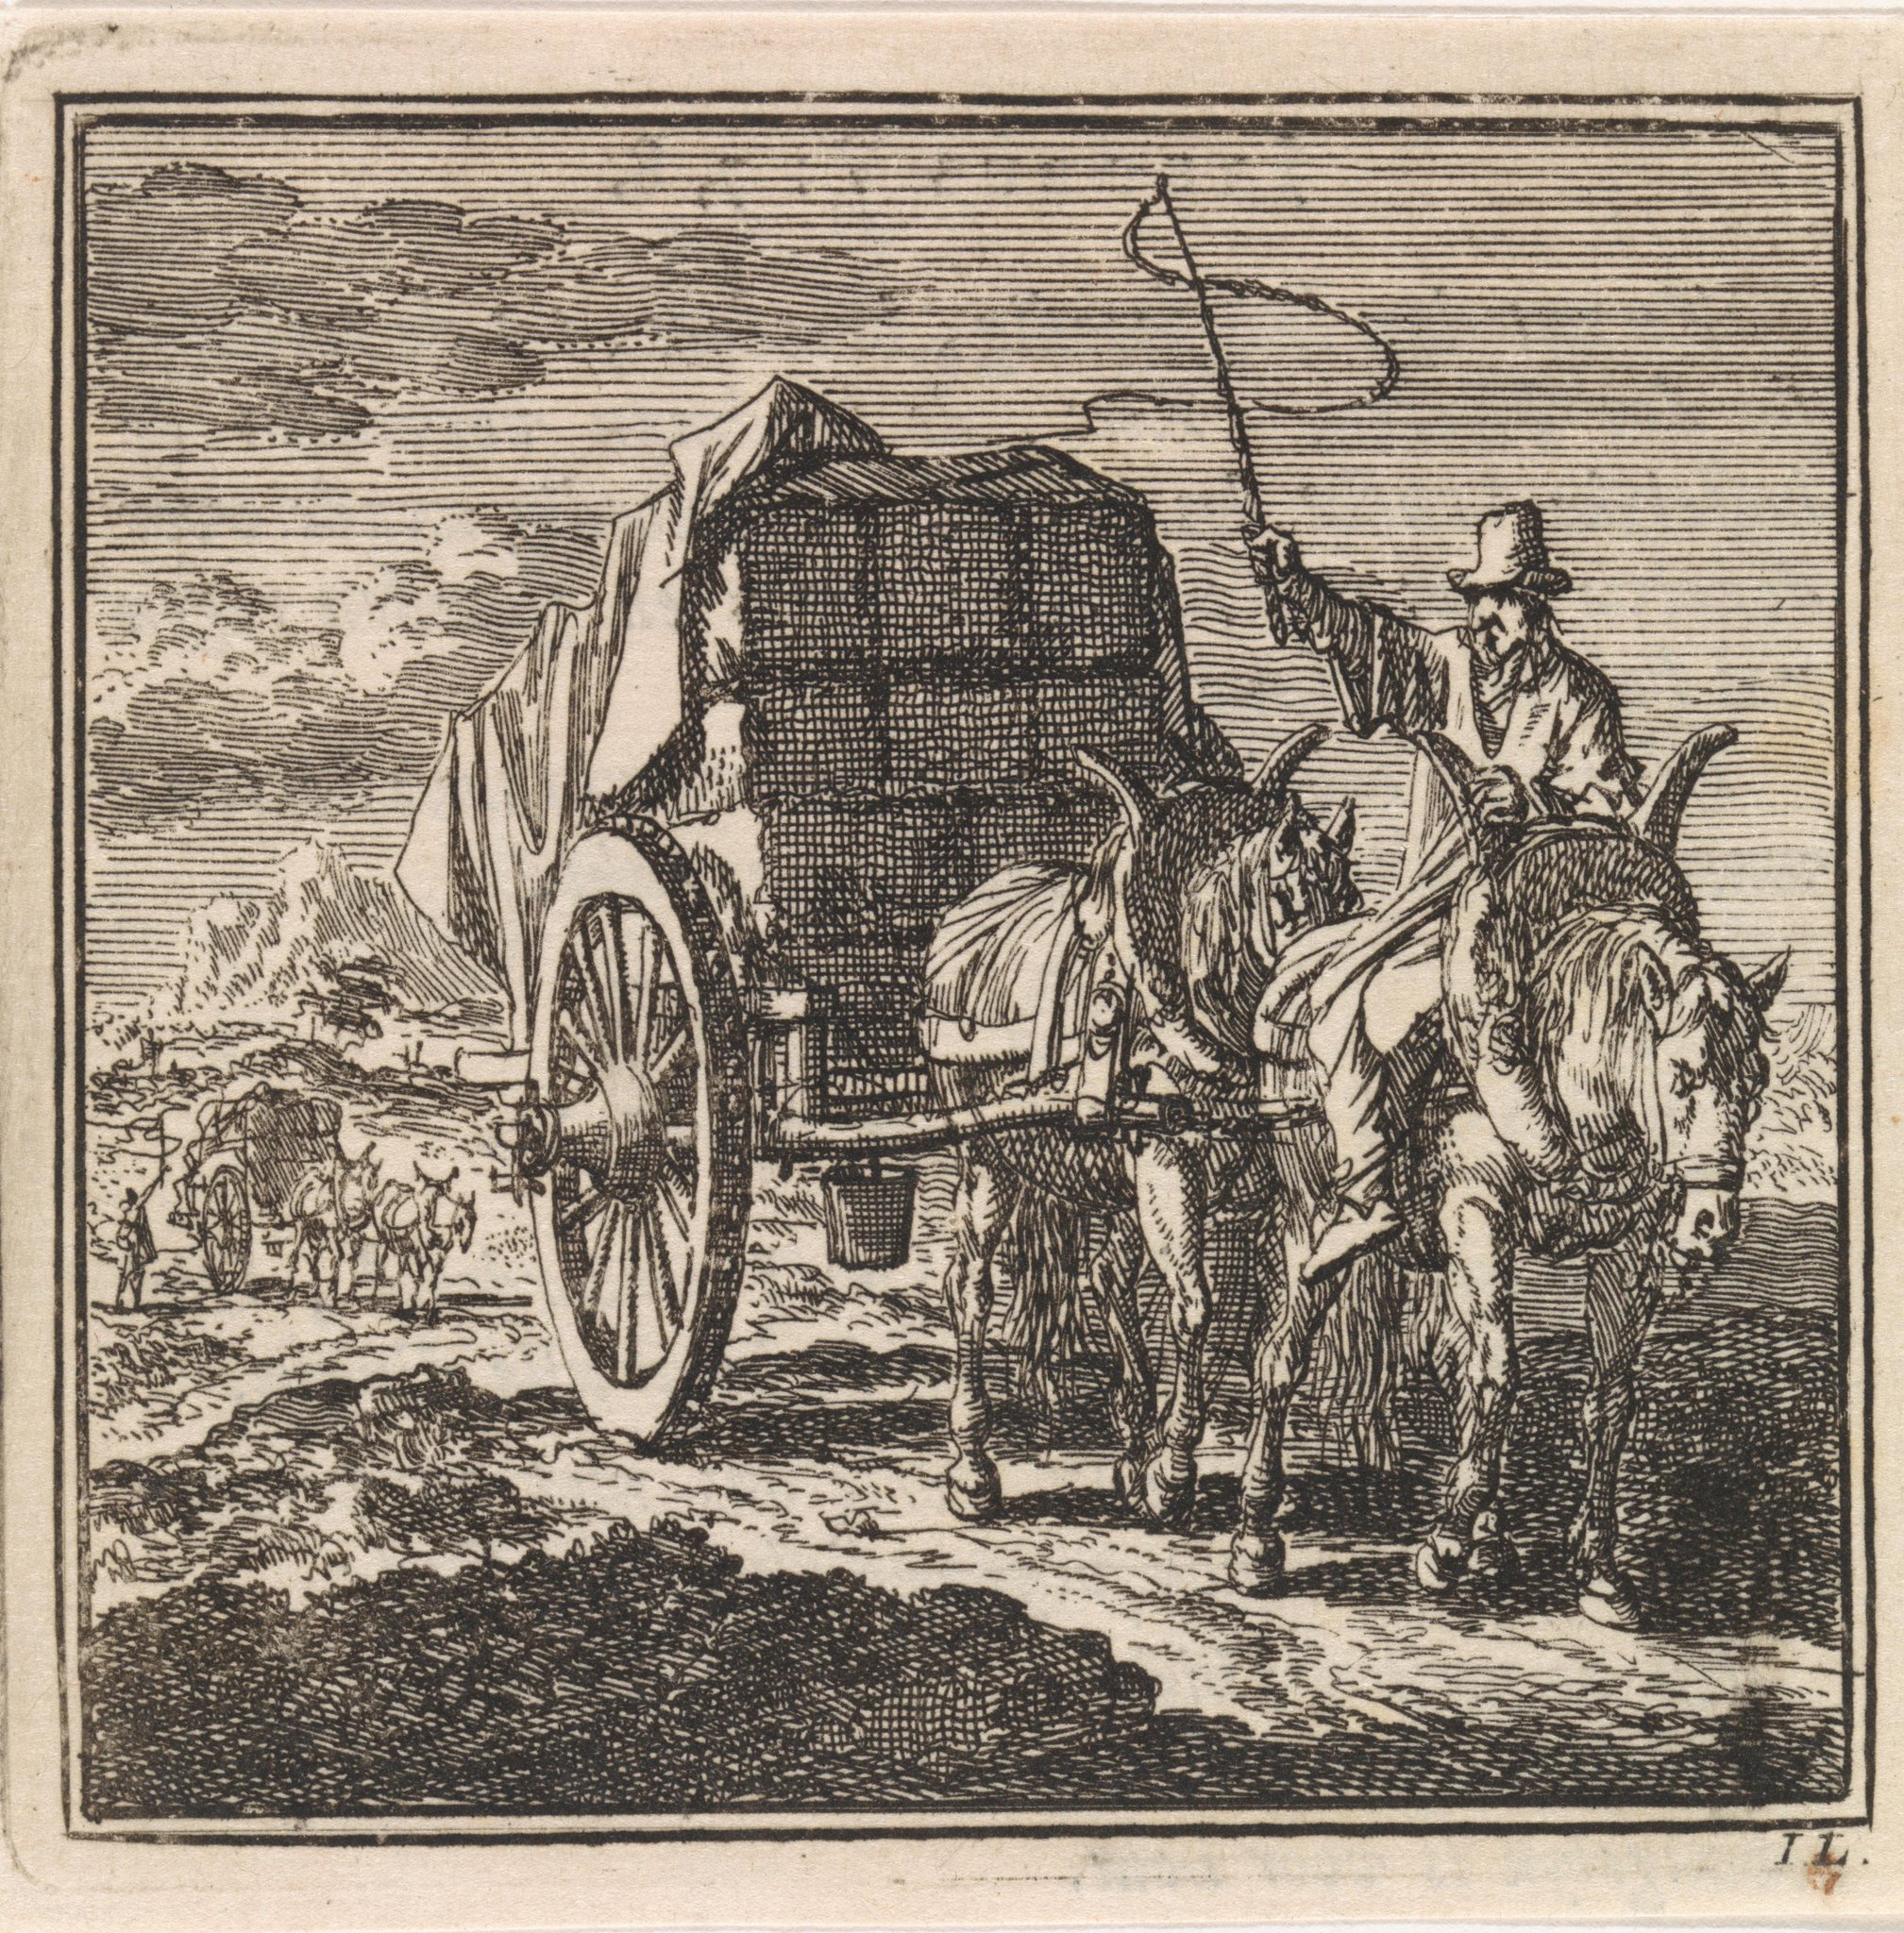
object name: print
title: De Pakgoederen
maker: jan luyken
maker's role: draughtsman, print maker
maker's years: 1649-1712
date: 1711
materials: paper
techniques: etching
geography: amsterdam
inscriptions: collector's mark: Lugt 2228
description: Illustratie voor: Luyken, Jan. De Bykorf des Gemoeds. Amsterdam: Pieter Arentsz. II (wed.) en Cornelis van der Sys, 1711, p. 202.